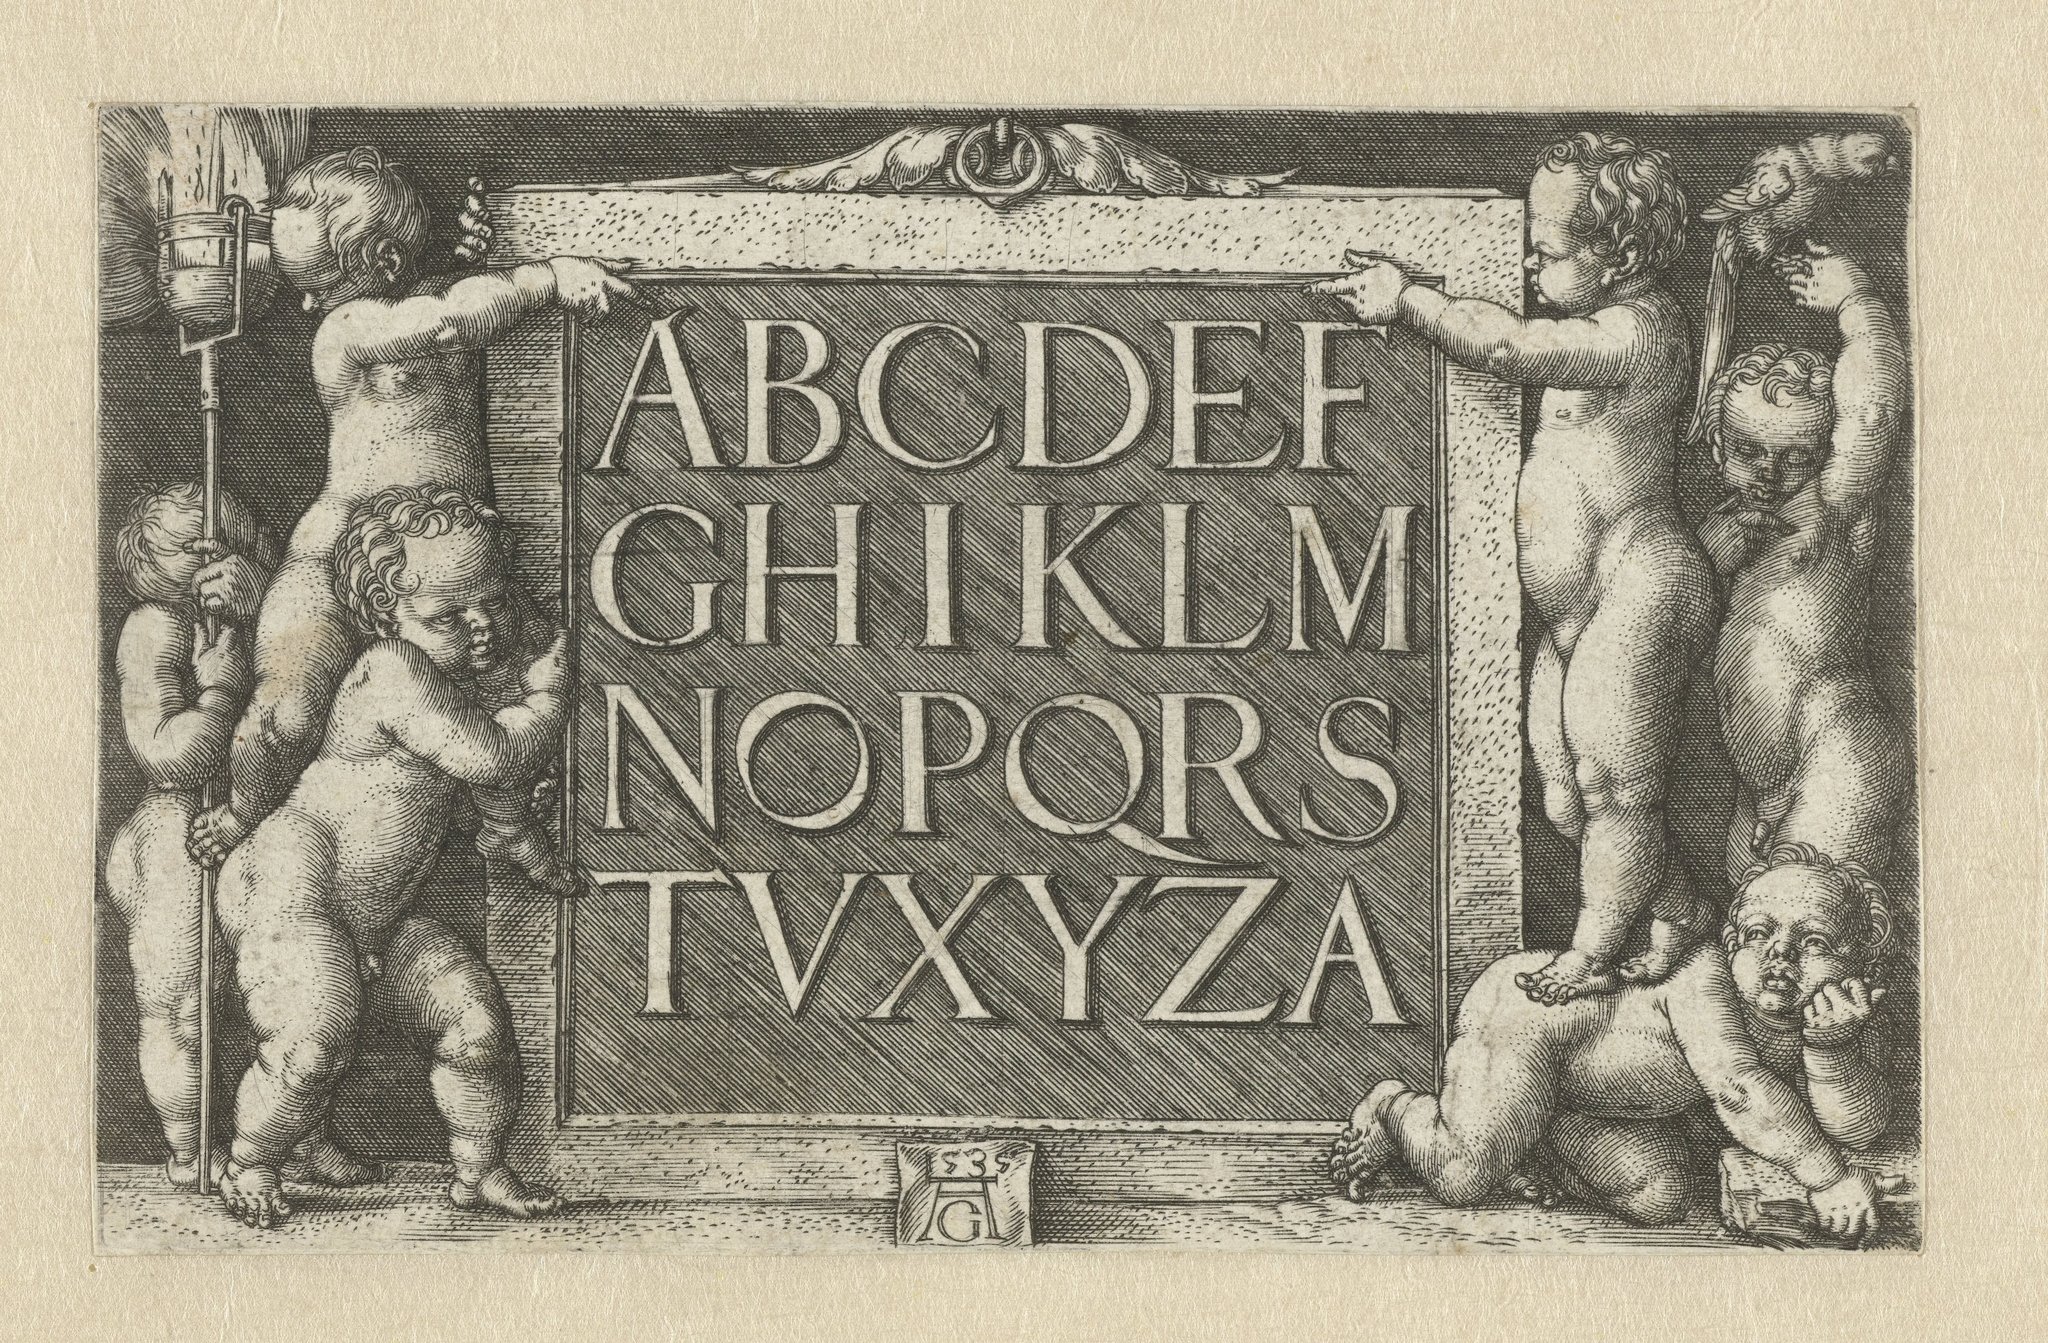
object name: print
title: Zes kinderen met een cartouche met het alfabet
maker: heinrich aldegrever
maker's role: draughtsman, print maker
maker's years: 1502-1561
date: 1535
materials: paper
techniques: engraving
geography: germany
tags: letters, alphabet, script, child, ornament ~ cartouche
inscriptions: number: ‘18’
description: Vlakdecoratie met een cartouche met het Latijnse alfabet. Links staan drie kinderen van wie twee de cartouche vasthouden en één een fakkel. Rechts ligt een kind op de grond, een tweede staat op zijn rug en houdt de cartouche vast en een derde heeft een paegaai op zijn hand.